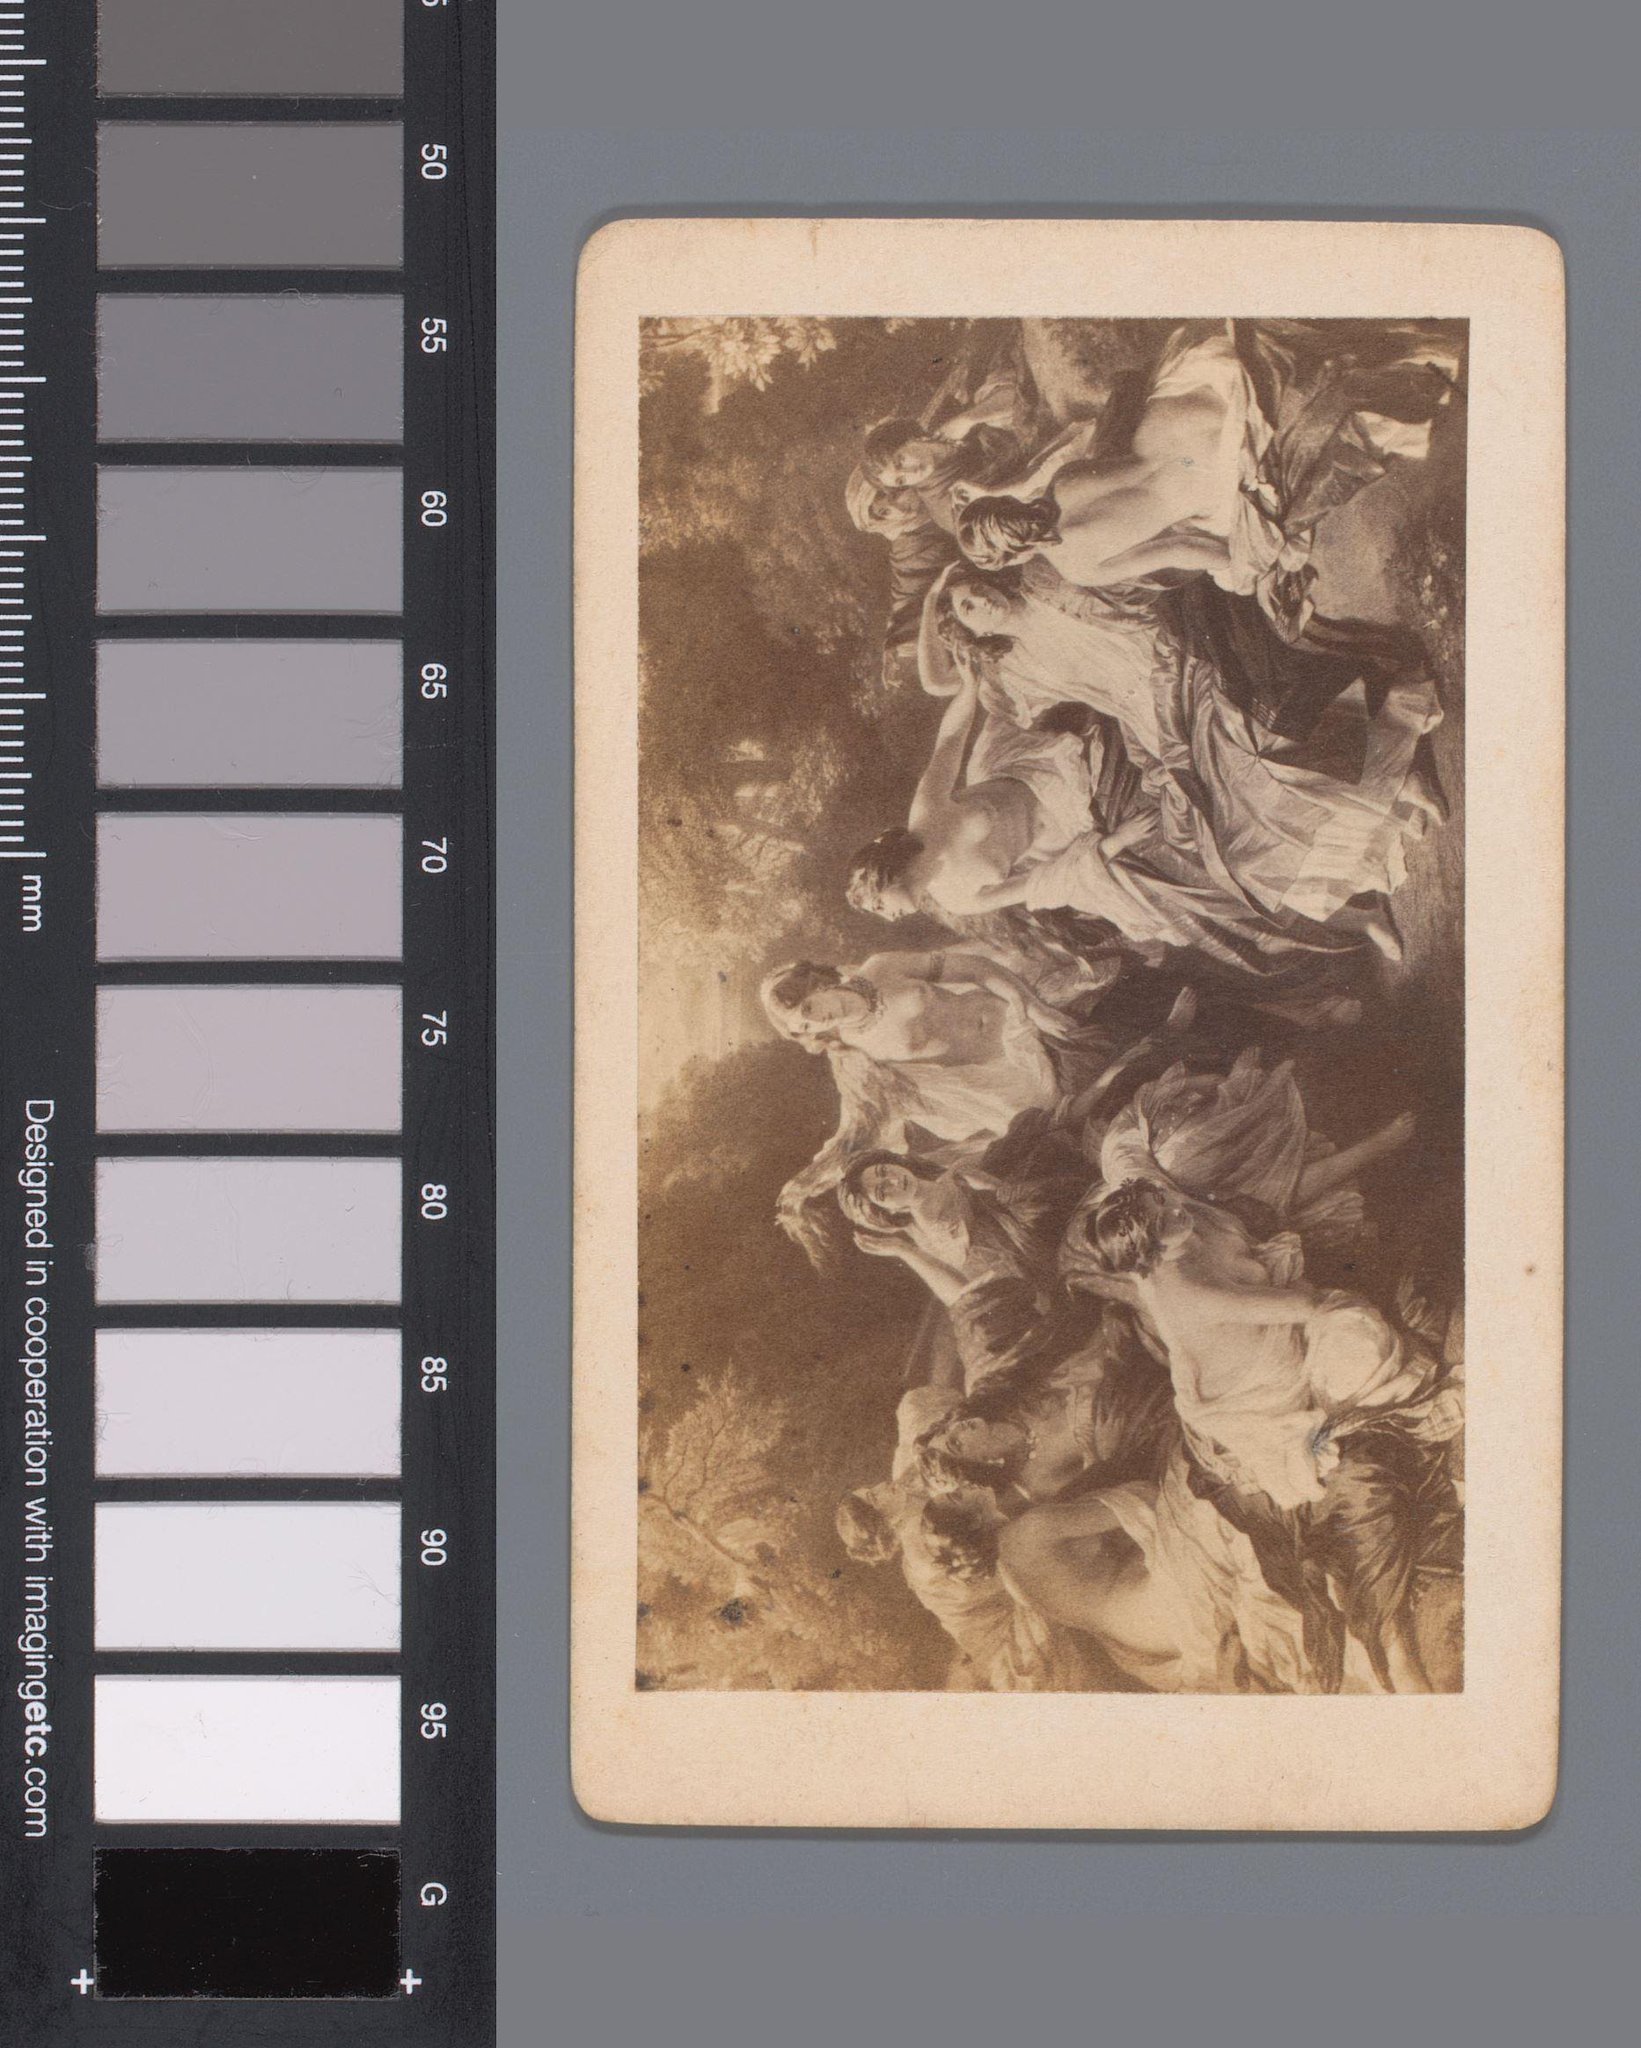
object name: reproduction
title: Fotoreproductie van een schilderij van een groep vrouwen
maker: Anonymous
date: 1855-1885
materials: cardboard, paper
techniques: albumen print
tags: 'après le bain' - aa - in the open air, adult woman, nude with covered genitals